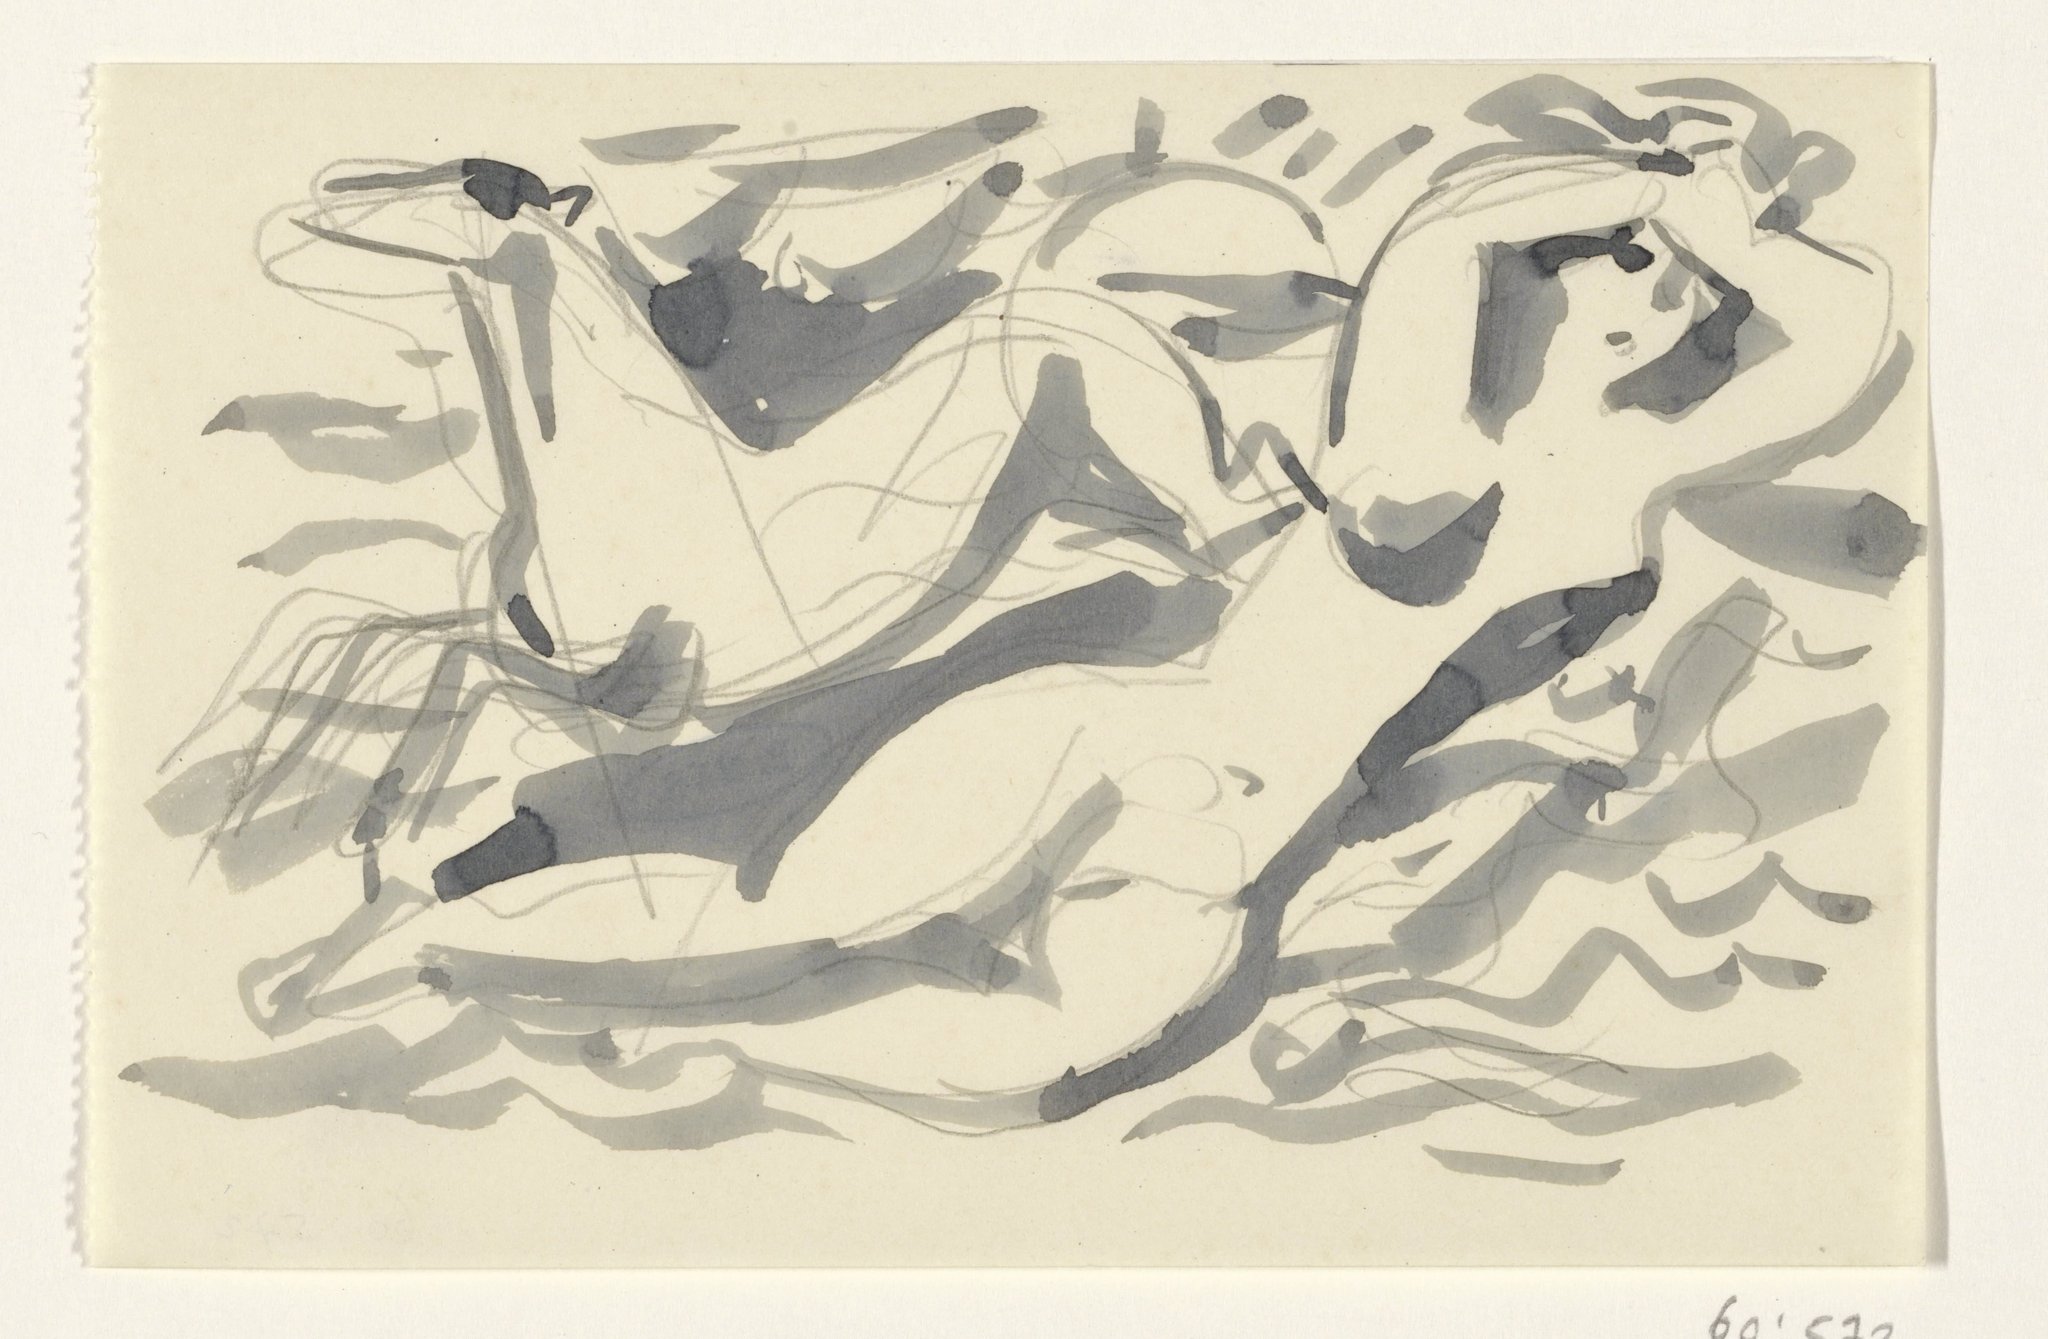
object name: drawing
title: Naakte vrouw en paard in de zee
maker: leo gestel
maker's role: draughtsman, print maker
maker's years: 1881-1941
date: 1891-1941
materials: ink, paper, pencil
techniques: brush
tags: female sex; woman (+ nude human being), sea (seascape), horse